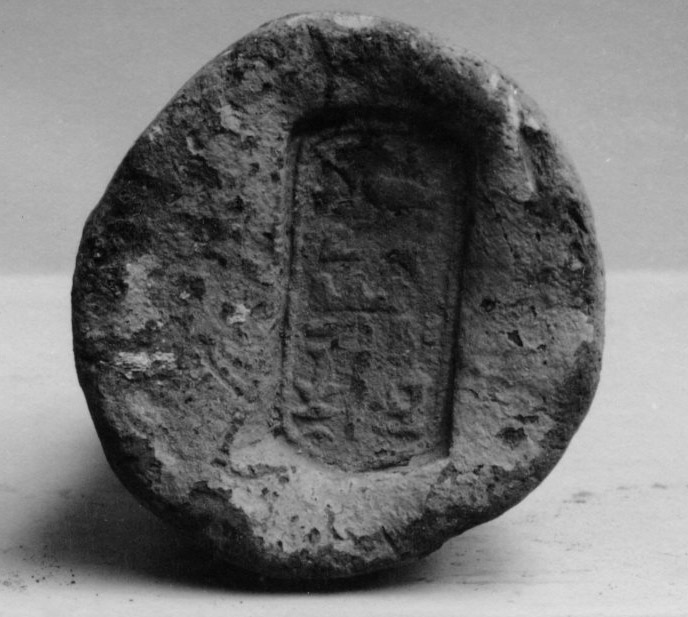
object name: cone, davy 342, sen, king's son, overseer, southern foreign land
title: Funerary Cone of Sen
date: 1550-1295 BCE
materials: pottery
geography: egypt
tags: hieroglyphs